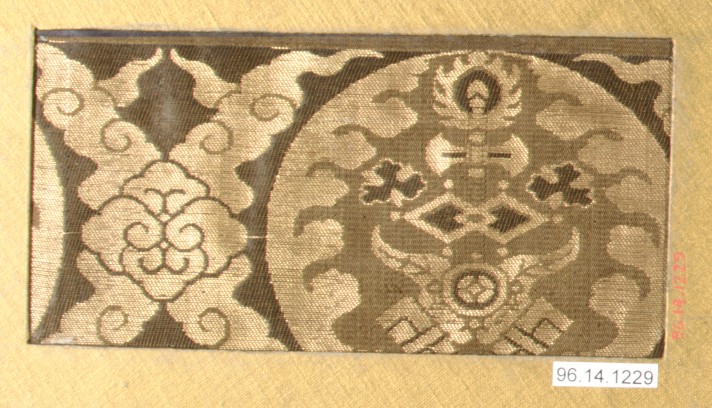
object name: piece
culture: japanese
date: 1701-1900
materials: silk